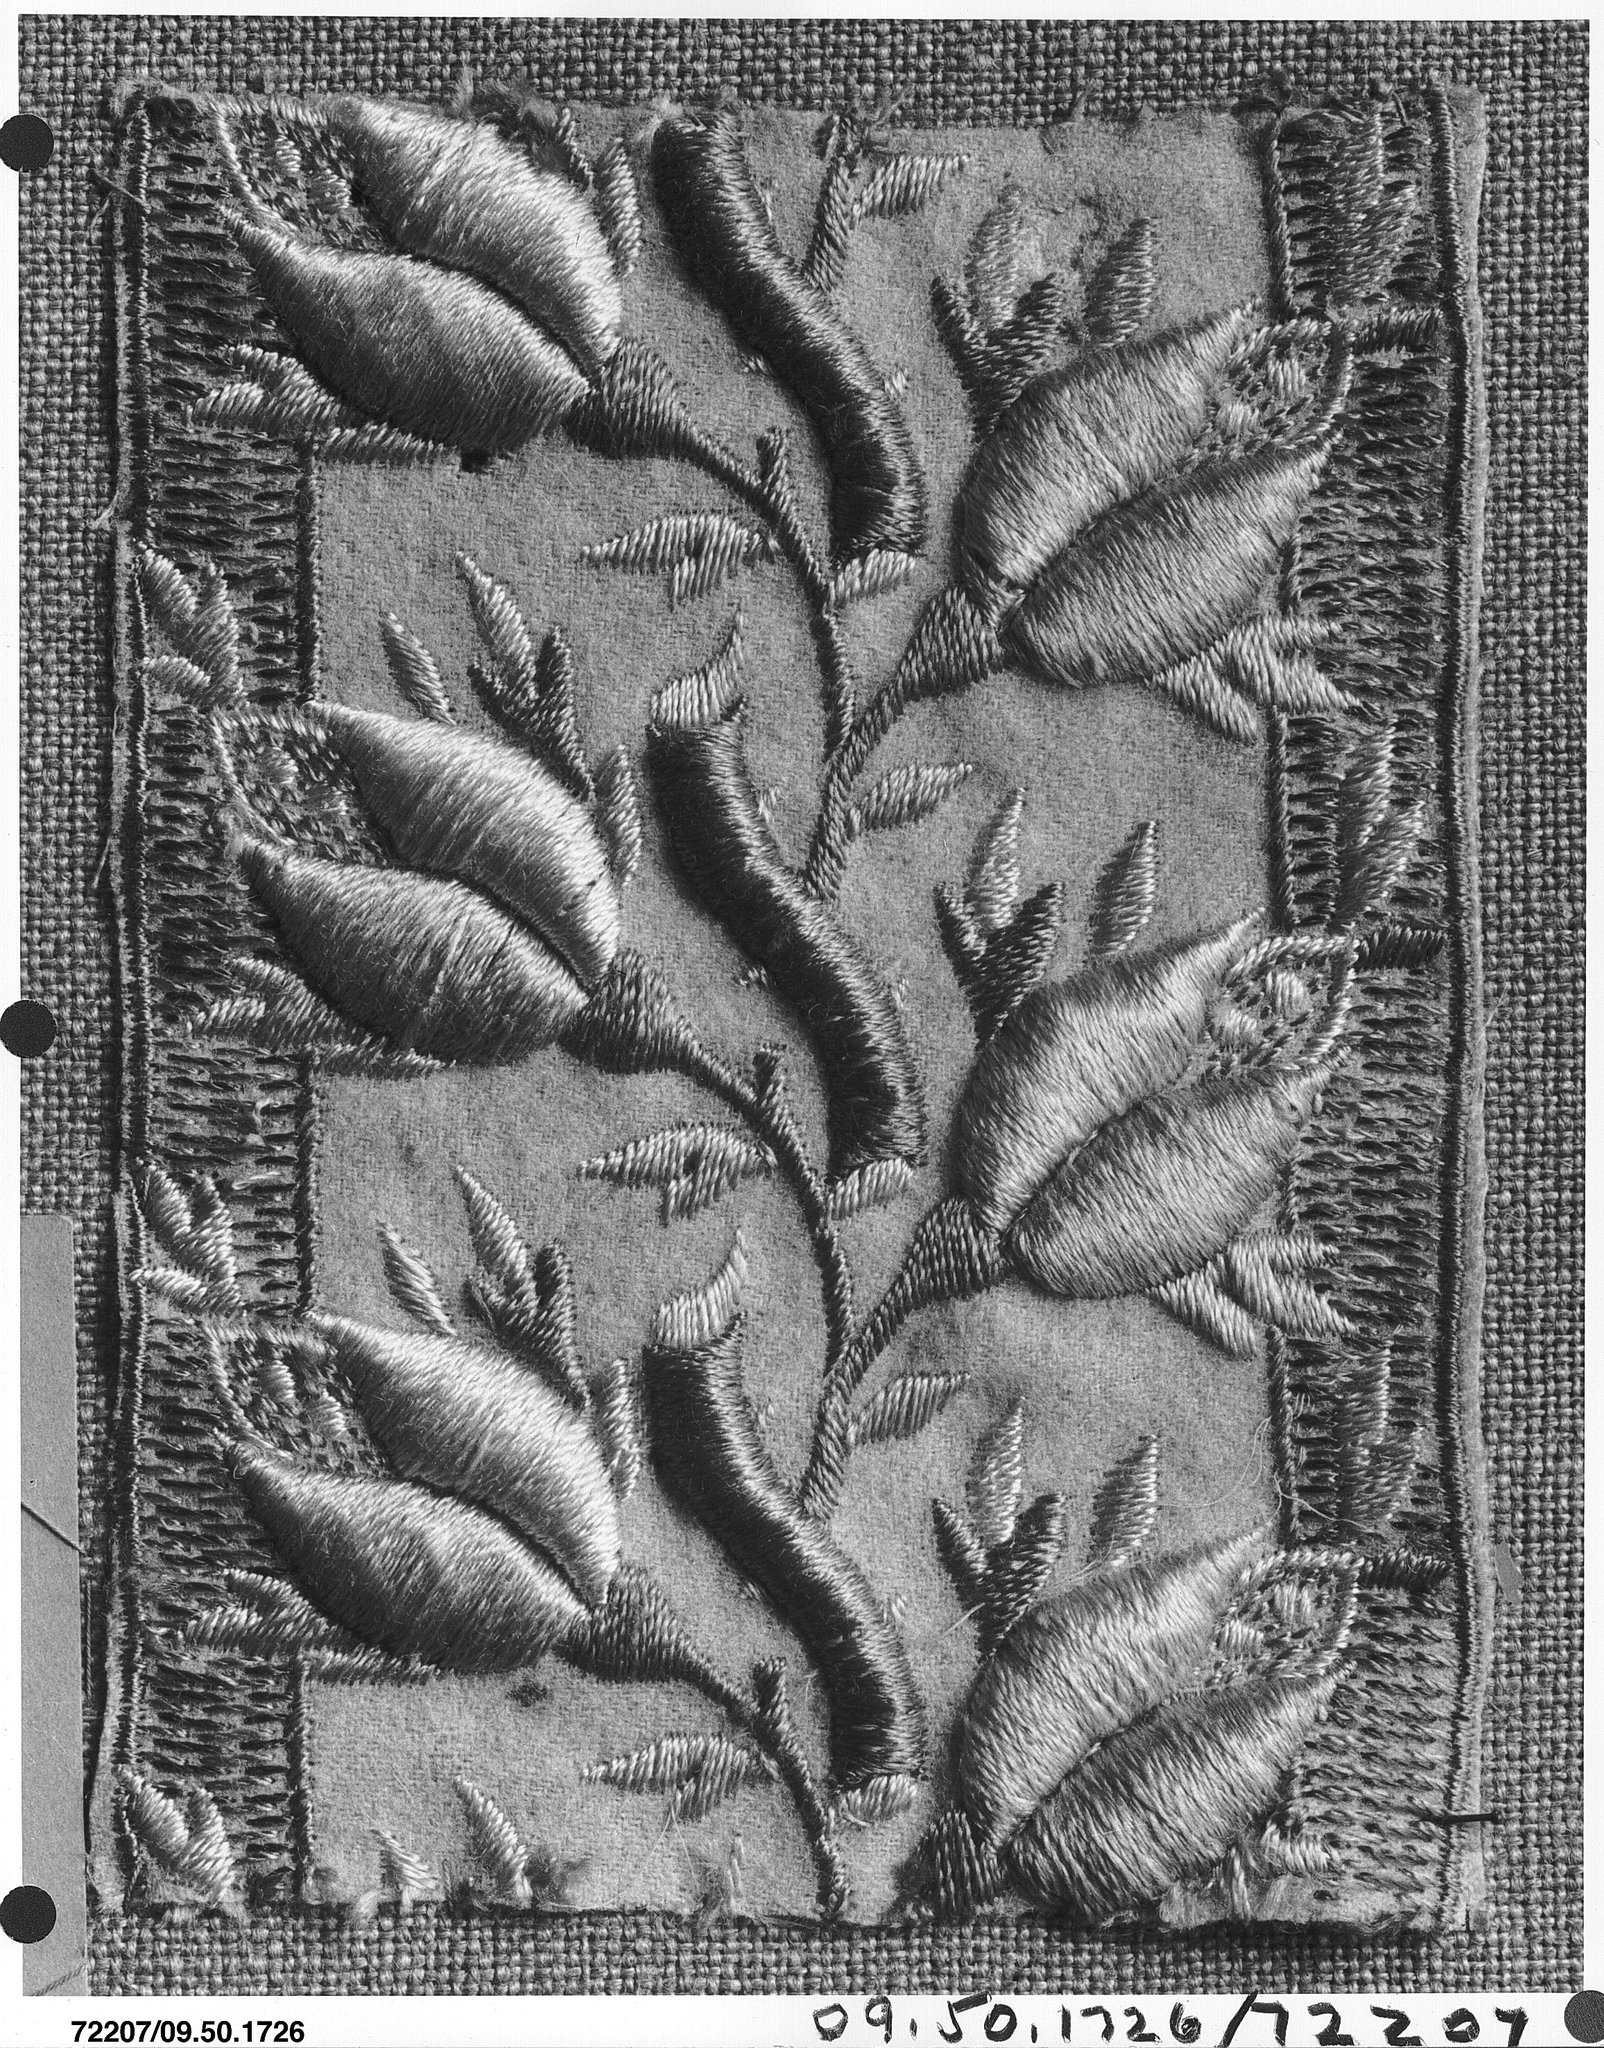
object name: fragment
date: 1801-1900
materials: silk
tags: flowers